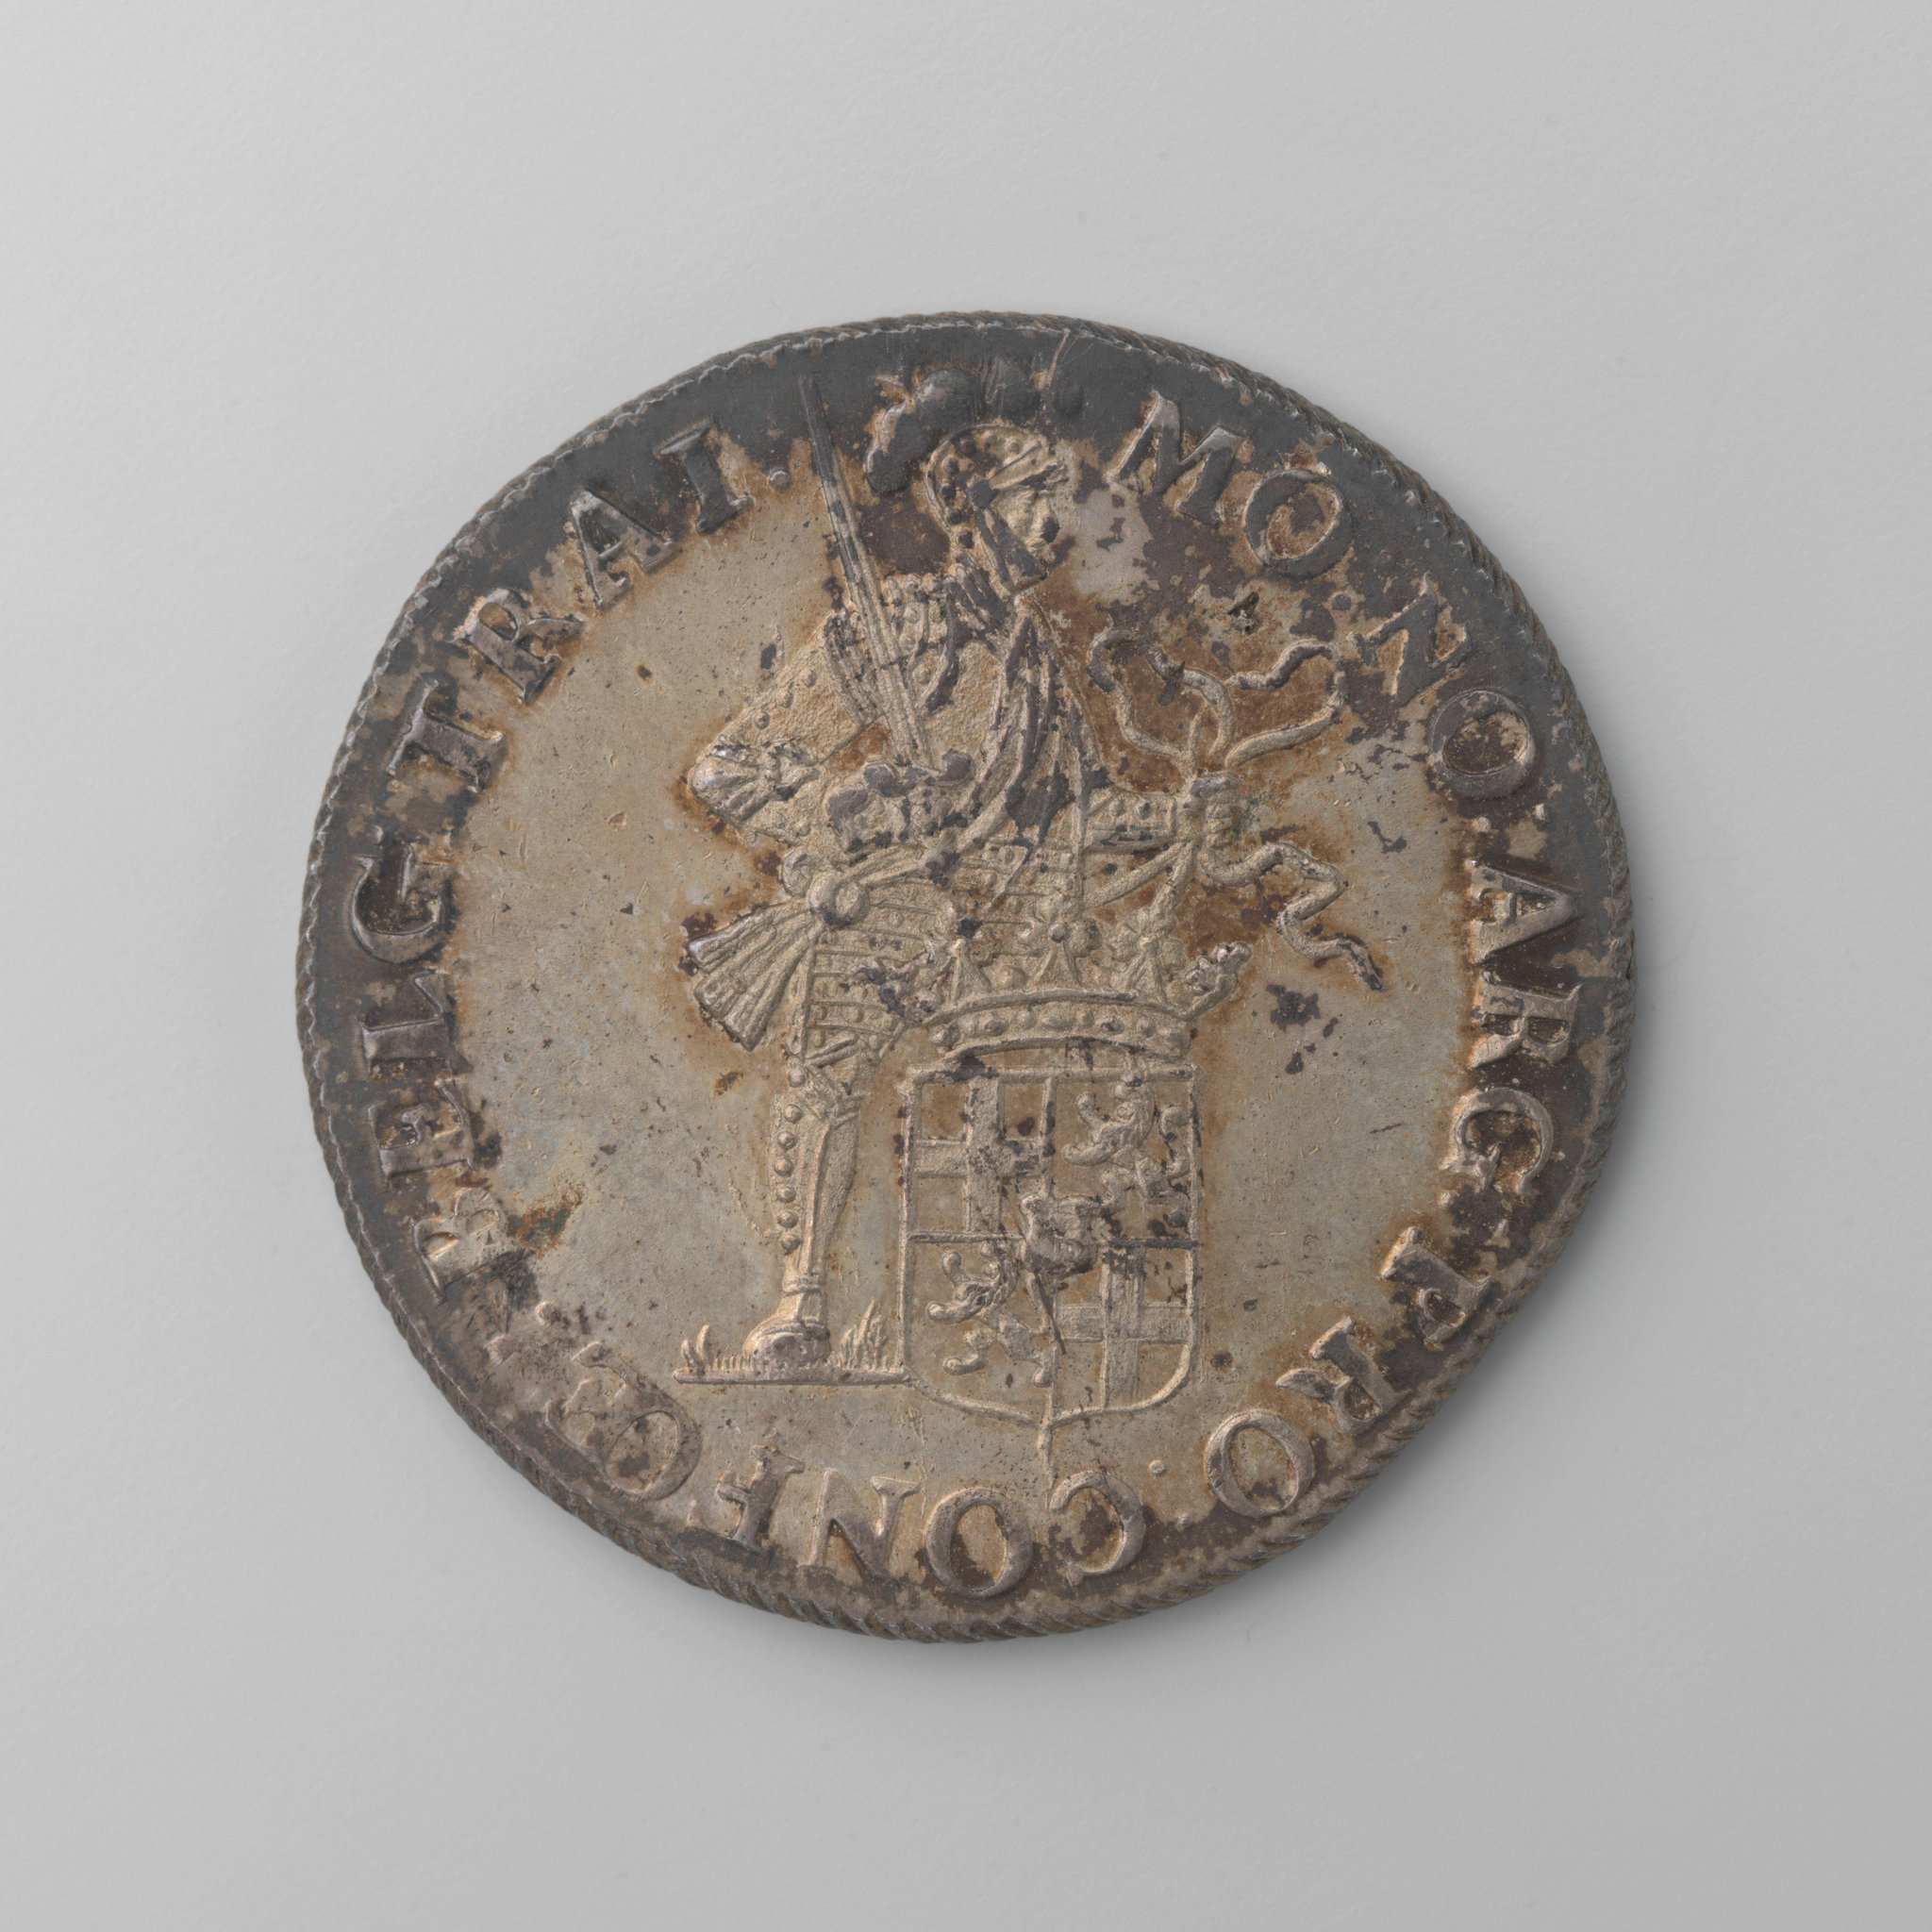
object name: zilveren dukaat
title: Zilveren dukaat van het Koninkrijk Holland op naam van Utrecht, 1808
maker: louis napoleon (king of holland)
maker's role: koning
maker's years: 1778-1846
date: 1808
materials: silver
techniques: striking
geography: utrecht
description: Zilveren munt. Voorzijde: tussen jaartal gekroond generaliteitswapenschild. Keerzijde: staande ridder met zwaard en het gekroonde wapenchild van Utrecht. Kabelrand.